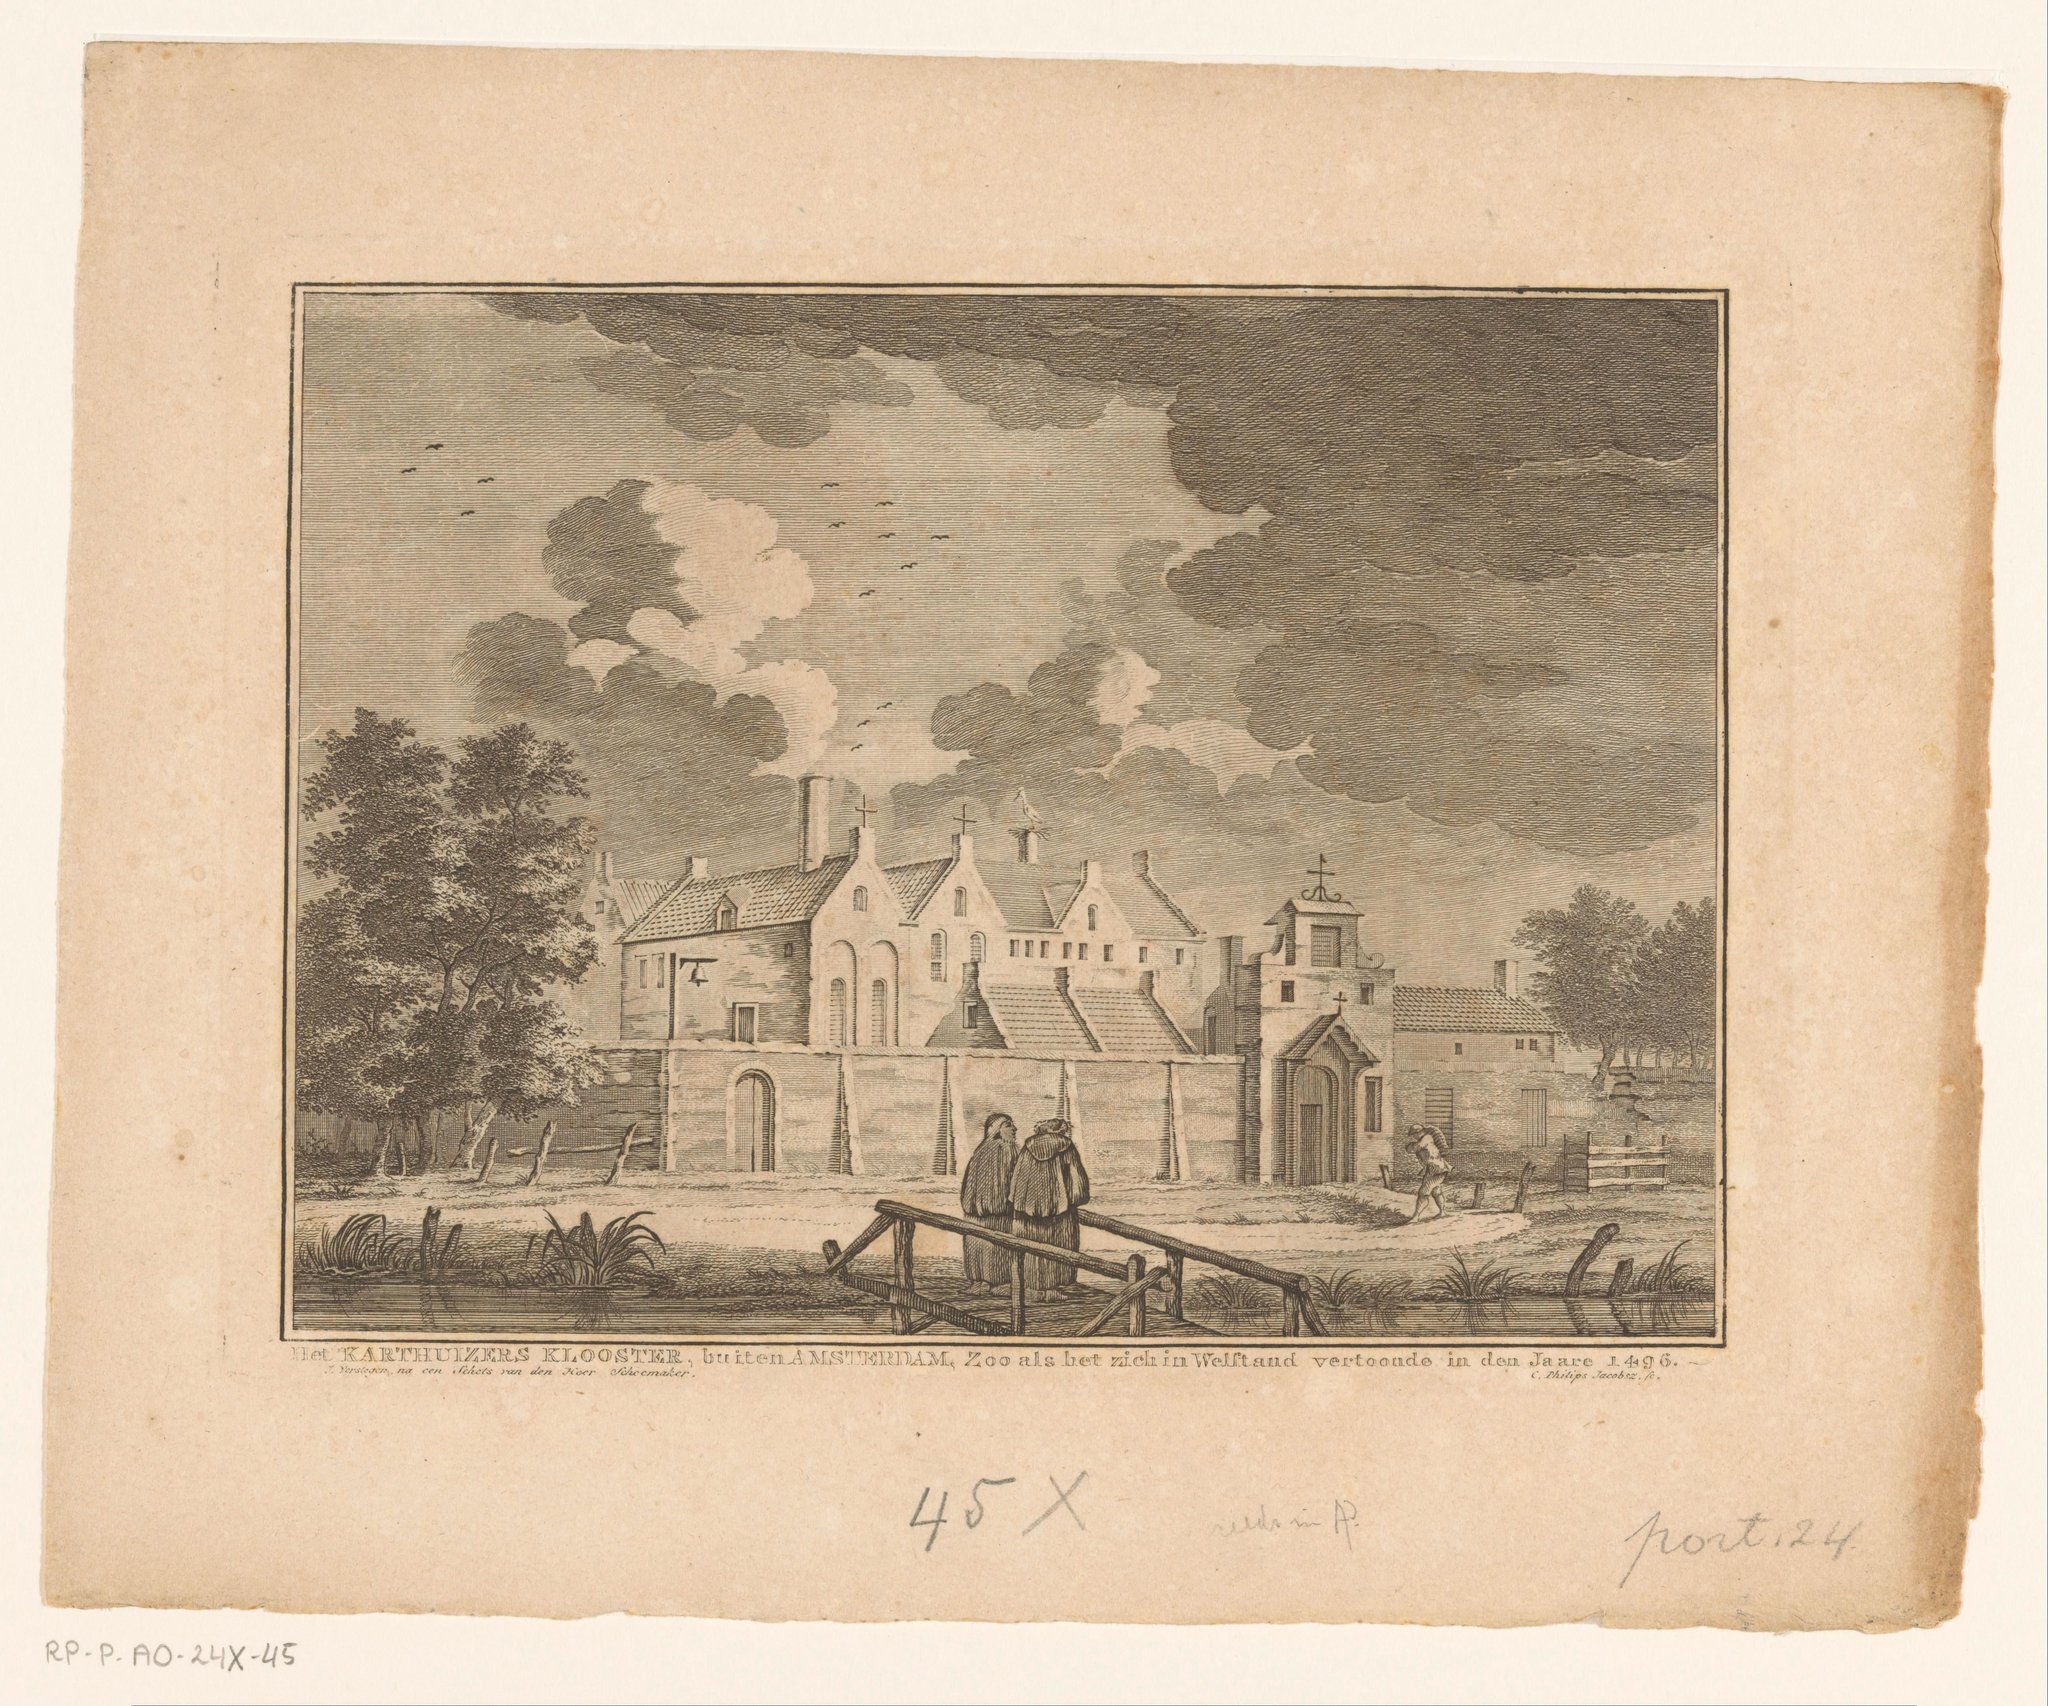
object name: print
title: Gezicht op het Kartuizerklooster buiten Amsterdam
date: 1752-1789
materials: paper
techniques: engraving, etching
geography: amsterdam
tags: abbey, monastery, convent ~ roman catholic church, monk(s), friar(s)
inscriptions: collector's mark: Lugt 2233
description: Deze prent is ook ingebonden in enkele exemplaren van: Wagenaar, Jan. Amsterdam, in zyne opkomst, aanwas, geschiedenissen (…). 3 delen [folio-uitgave]. Amsterdam: Isaak Tirion en Yntema & Tieboel, 1760-1767, dl. 2 (Isaak Tirion, 1765). Komt echter niet voor in de lijst met in te binden prenten van deze uitgave (te vinden in dl. 3) - en is er dus ook niet voor bedoeld. Zie ook RP-P-AO-24X-43-1, RP-P-AO-24X-43-2 en RP-P-AO-24X-44.